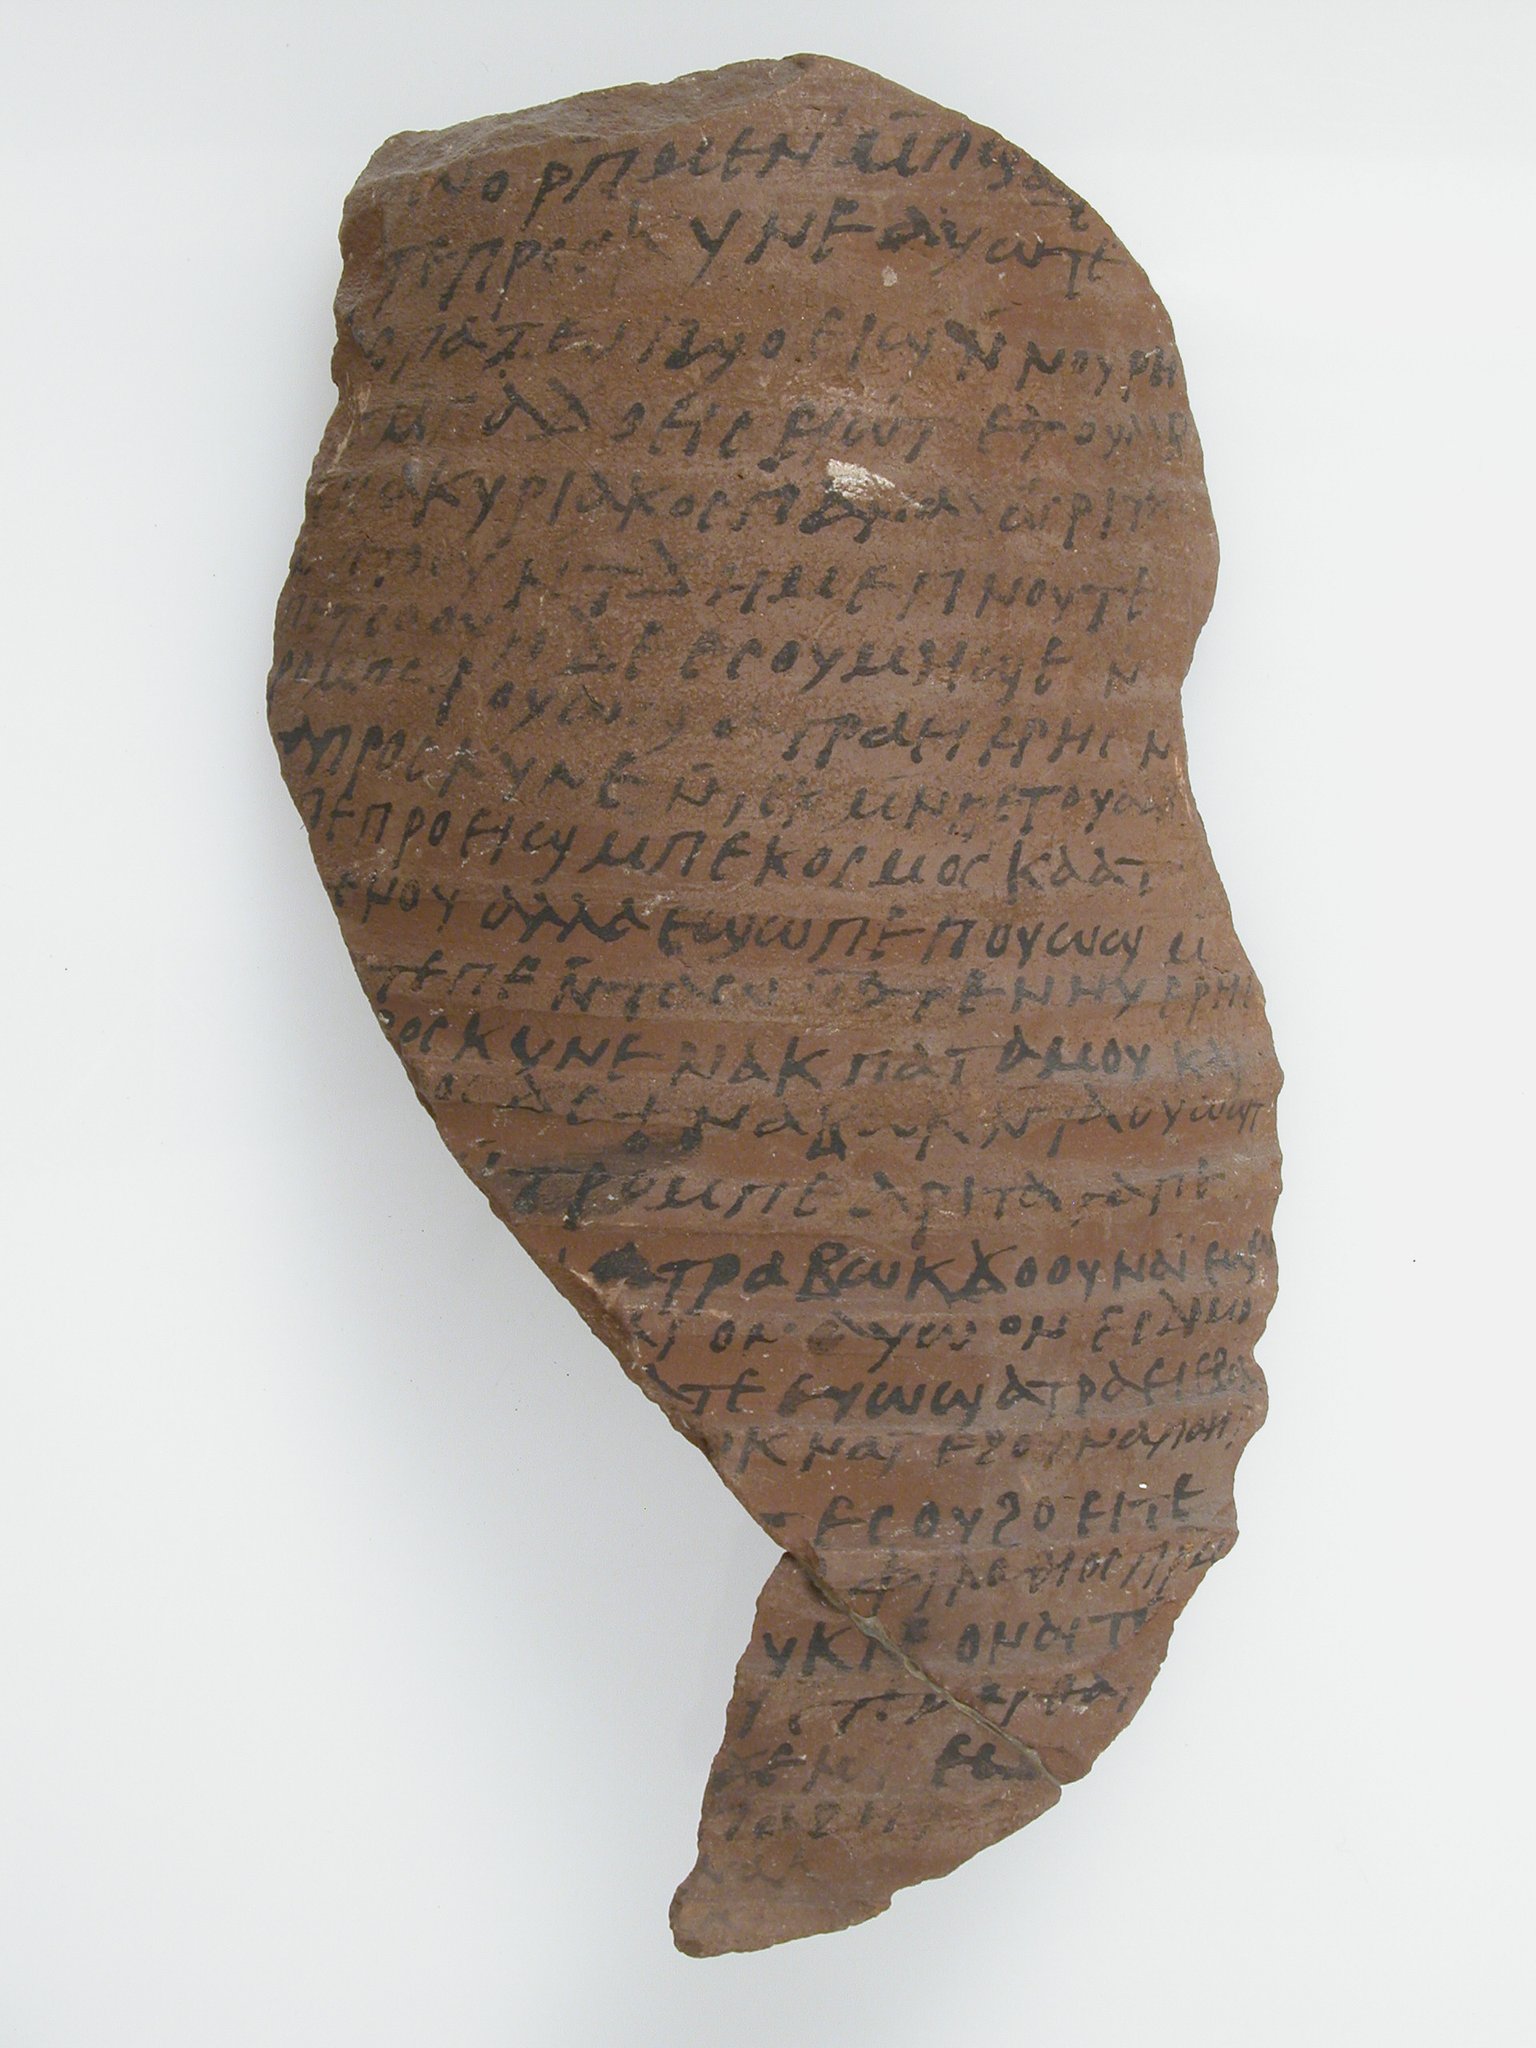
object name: ostrakon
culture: coptic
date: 600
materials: ink, pottery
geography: egypt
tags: coptic,documents